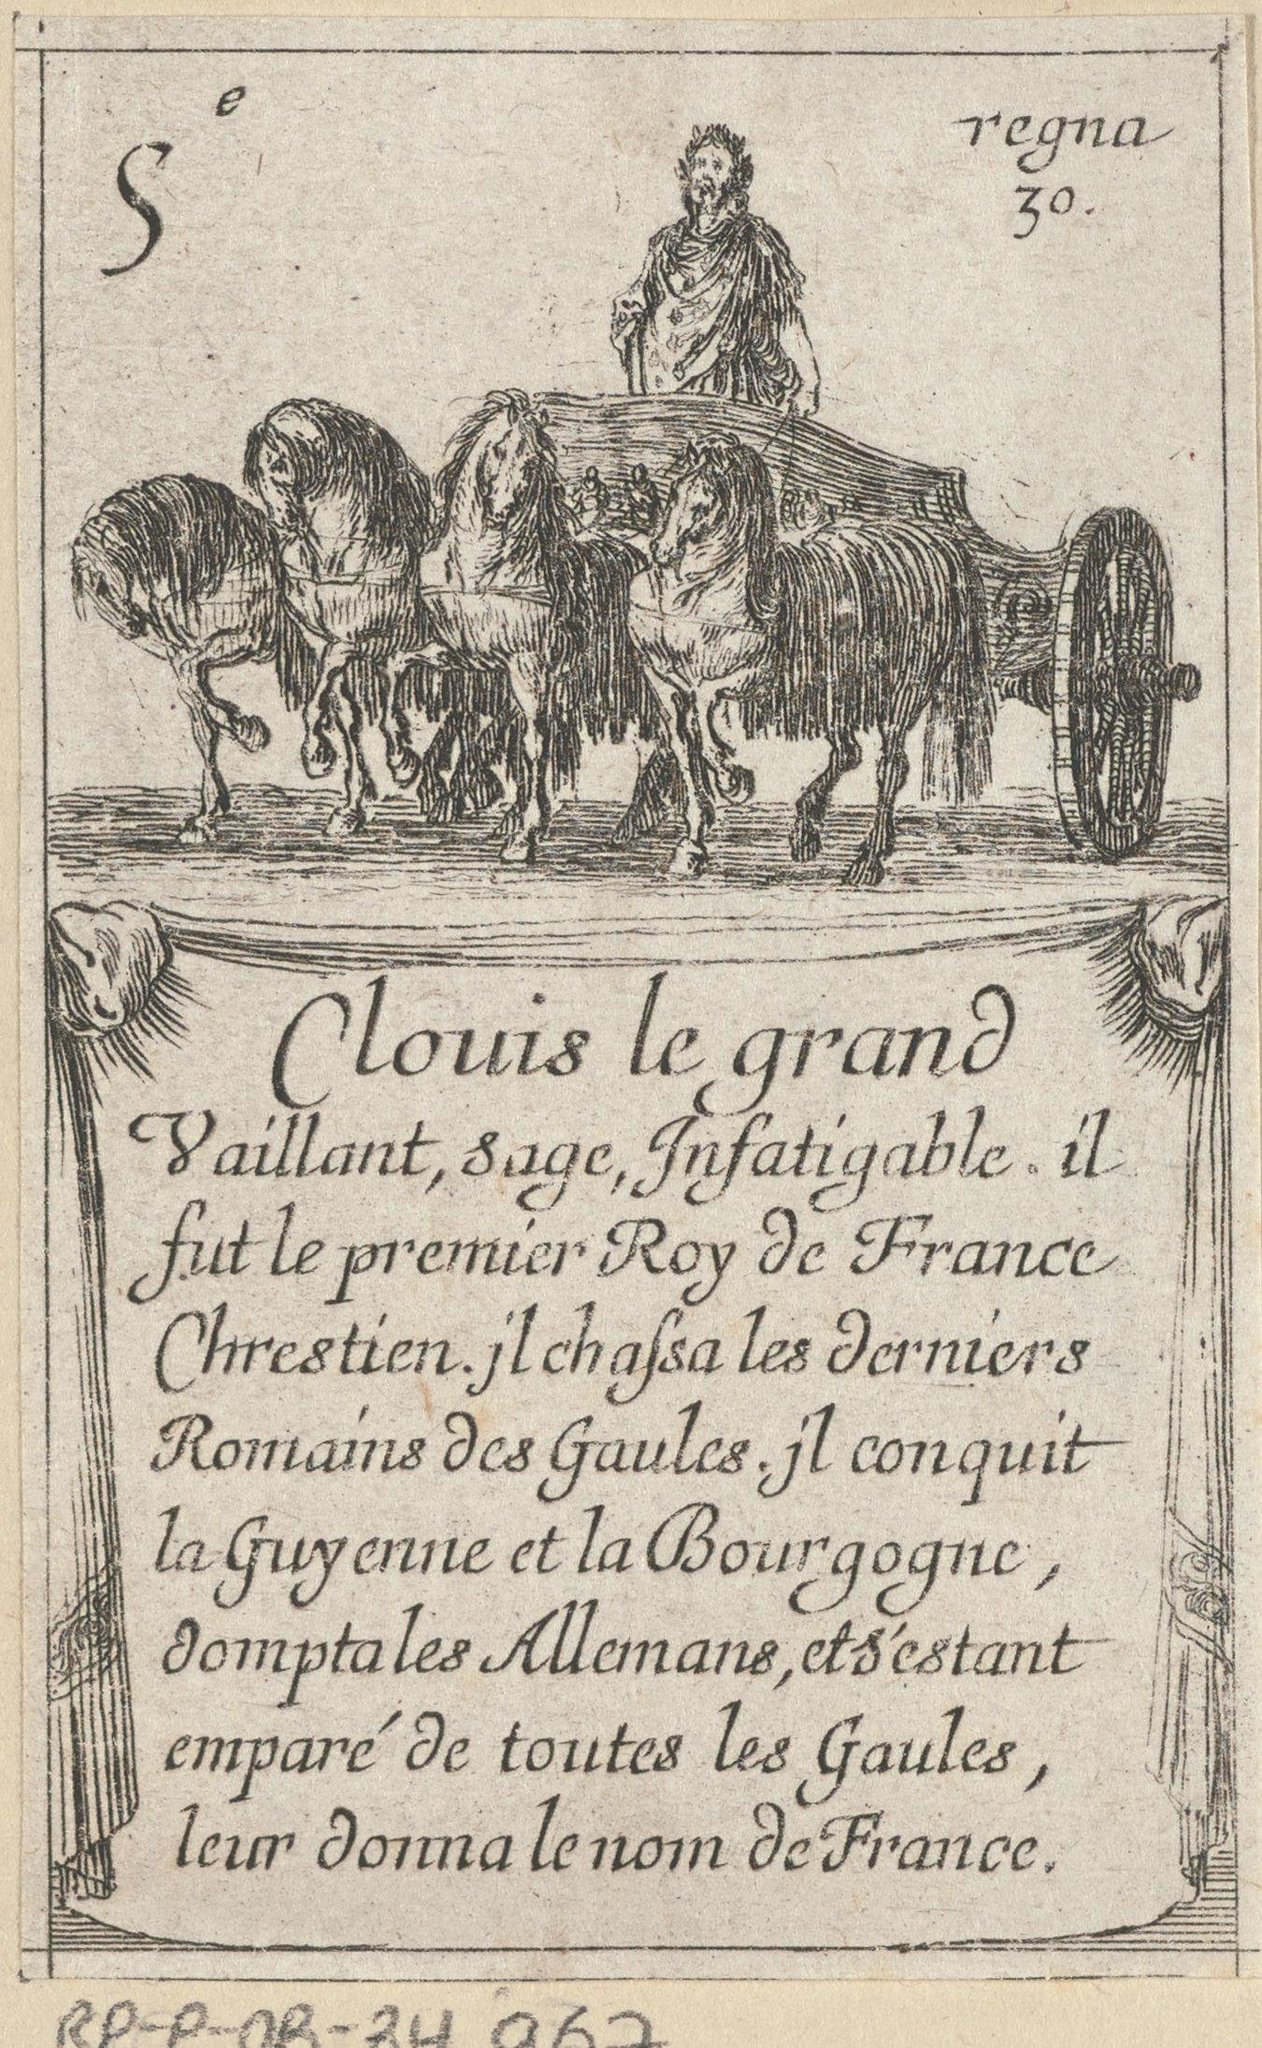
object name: playing card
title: Clouis le grand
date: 1620-1664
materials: paper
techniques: etching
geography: paris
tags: paris, ruler, sovereign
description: Deze prent maakt deel uit van een kaartspel met 39 kaarten met voorstellingen van Franse koningen. De serie is uitgedacht door Jean Desmarests de Saint-Sorlin in opdracht van Kardinaal Mazarin. Het kaartspel werd gemaakt voor de jonge Lodewijk XIV, samen met het Jeu des Fables, Jeu des Reynes Renommées en Jeu de la géographie.